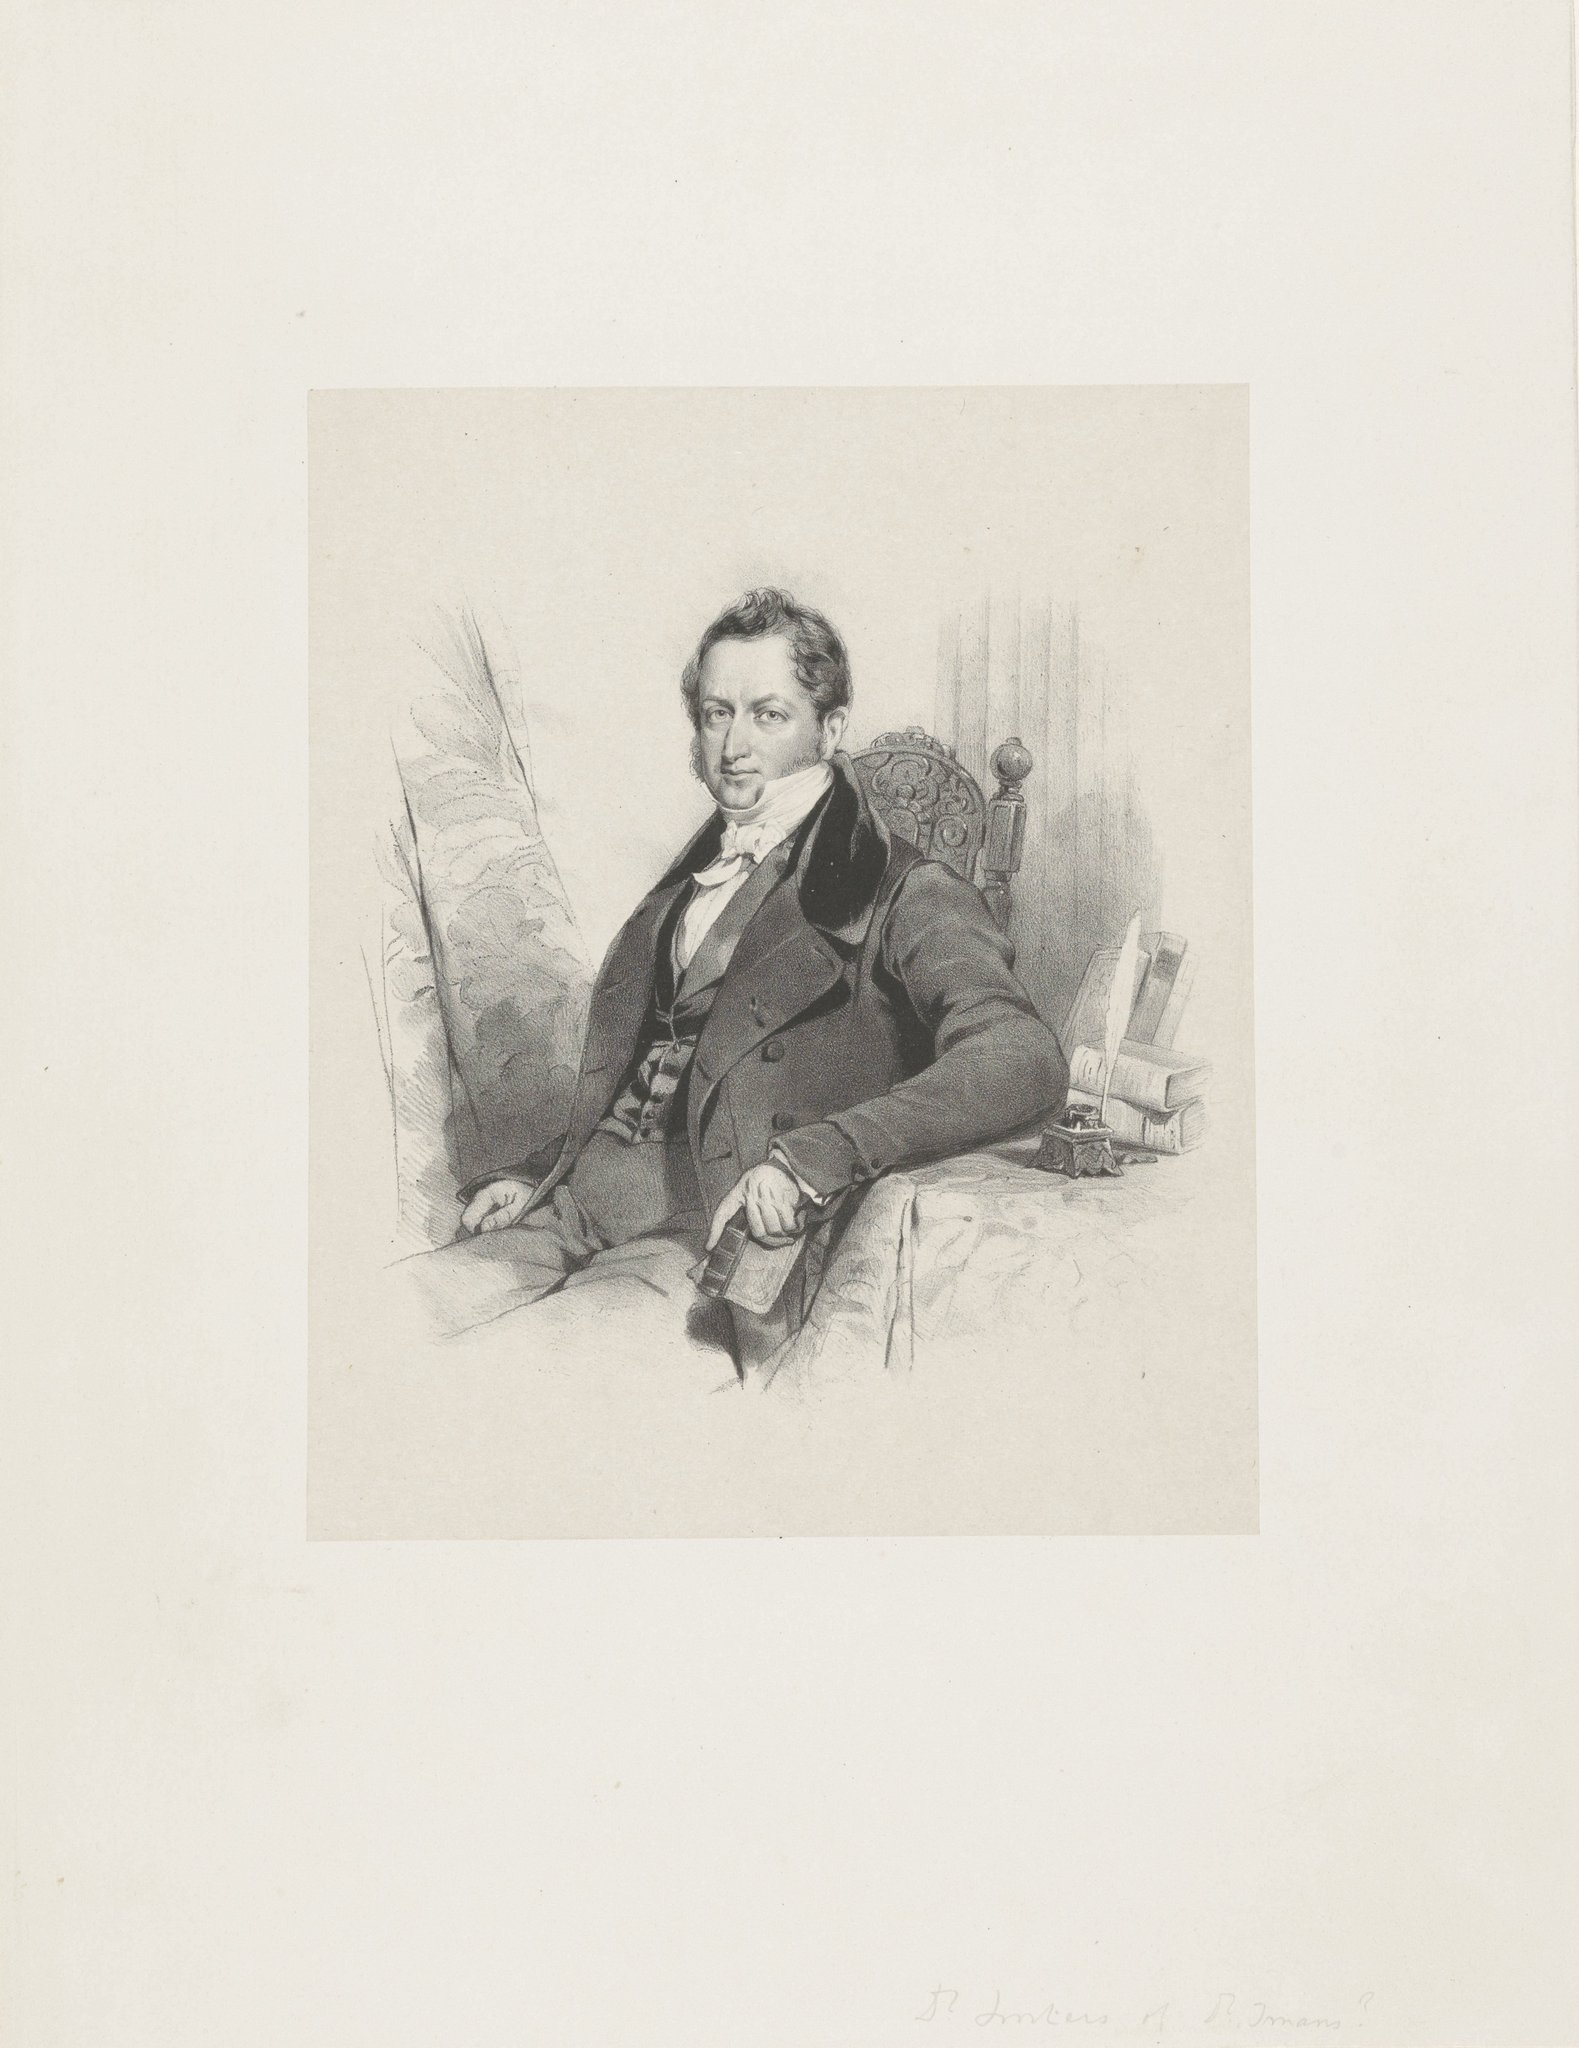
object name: print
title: Portret van de heer Imans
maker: adrianus johannes ehnle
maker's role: draughtsman, print maker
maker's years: 1819-1863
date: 1829-1863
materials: paper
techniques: lithograph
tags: writing tools, book, historical persons (+ half-length portrait)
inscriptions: collector's mark: Lugt 2228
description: De geportretteerde zit op een stoel aan tafel. In zijn linkerhandheeft hij een boek. Op de tafel liggen boeken en schrijfgerei.